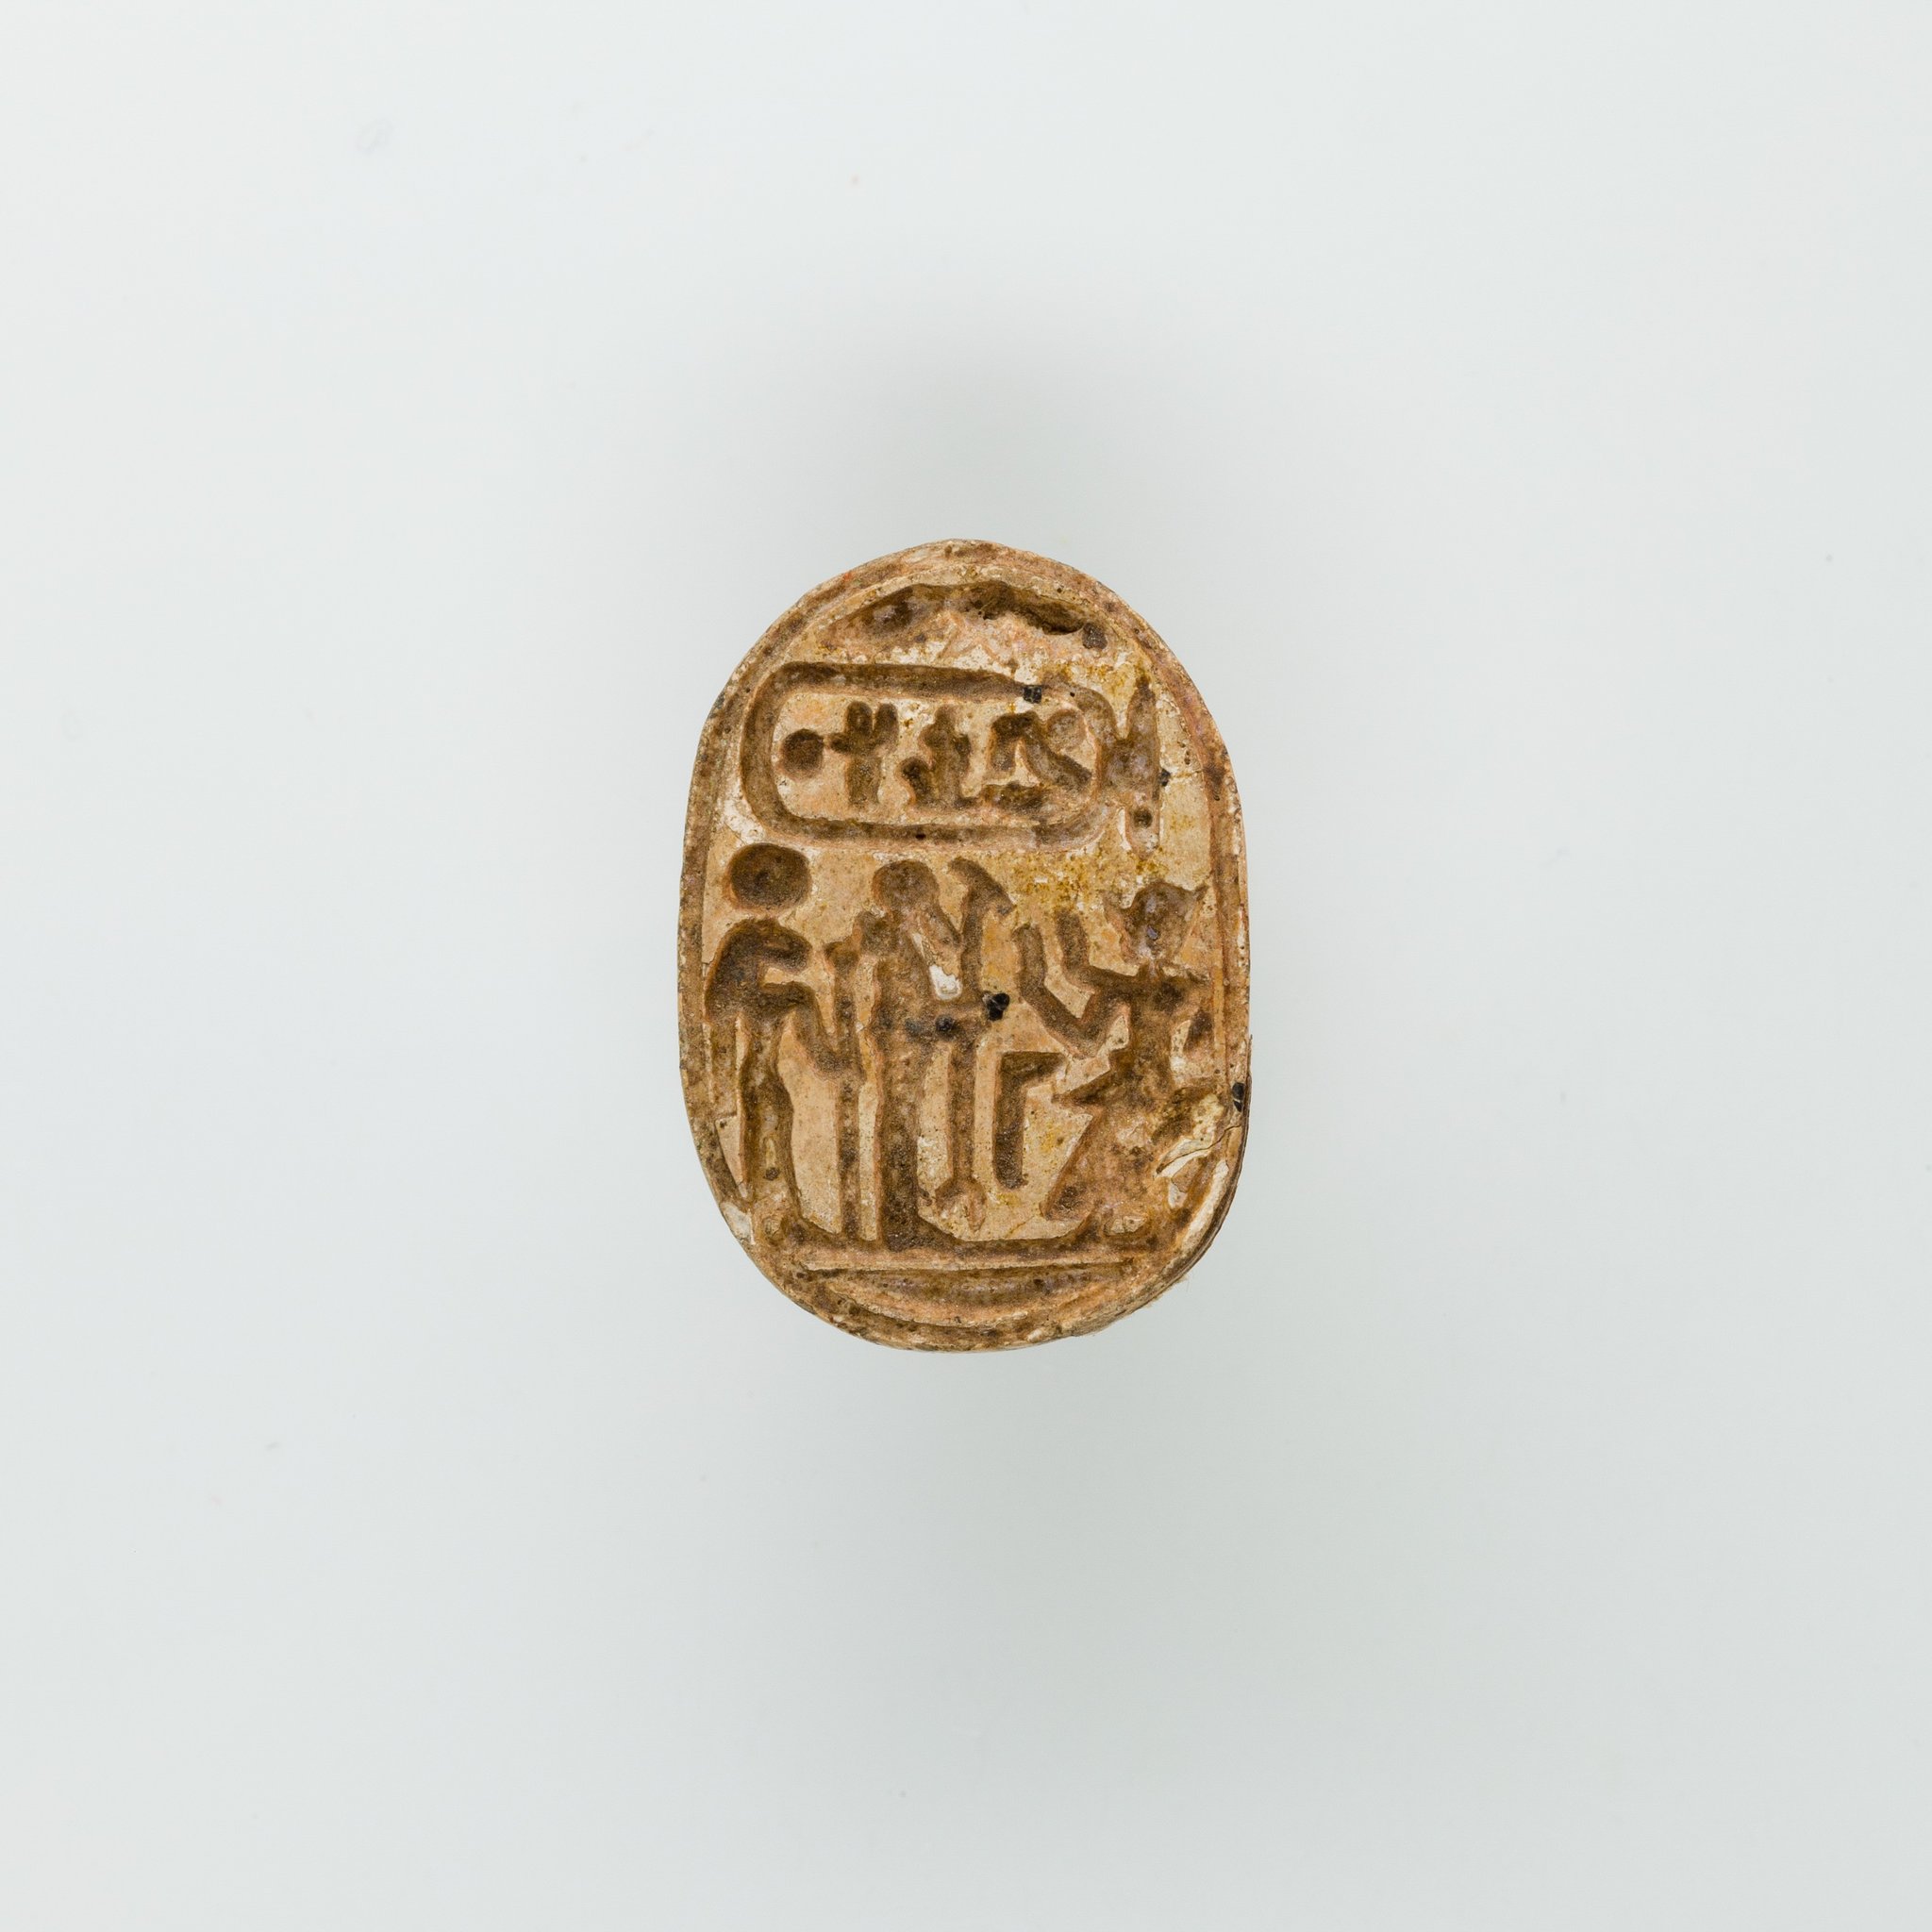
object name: scarab, ramesses ii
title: Scarab of Ramesses II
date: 1295-1070 BCE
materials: stone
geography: egypt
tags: hieroglyphs,scarabs